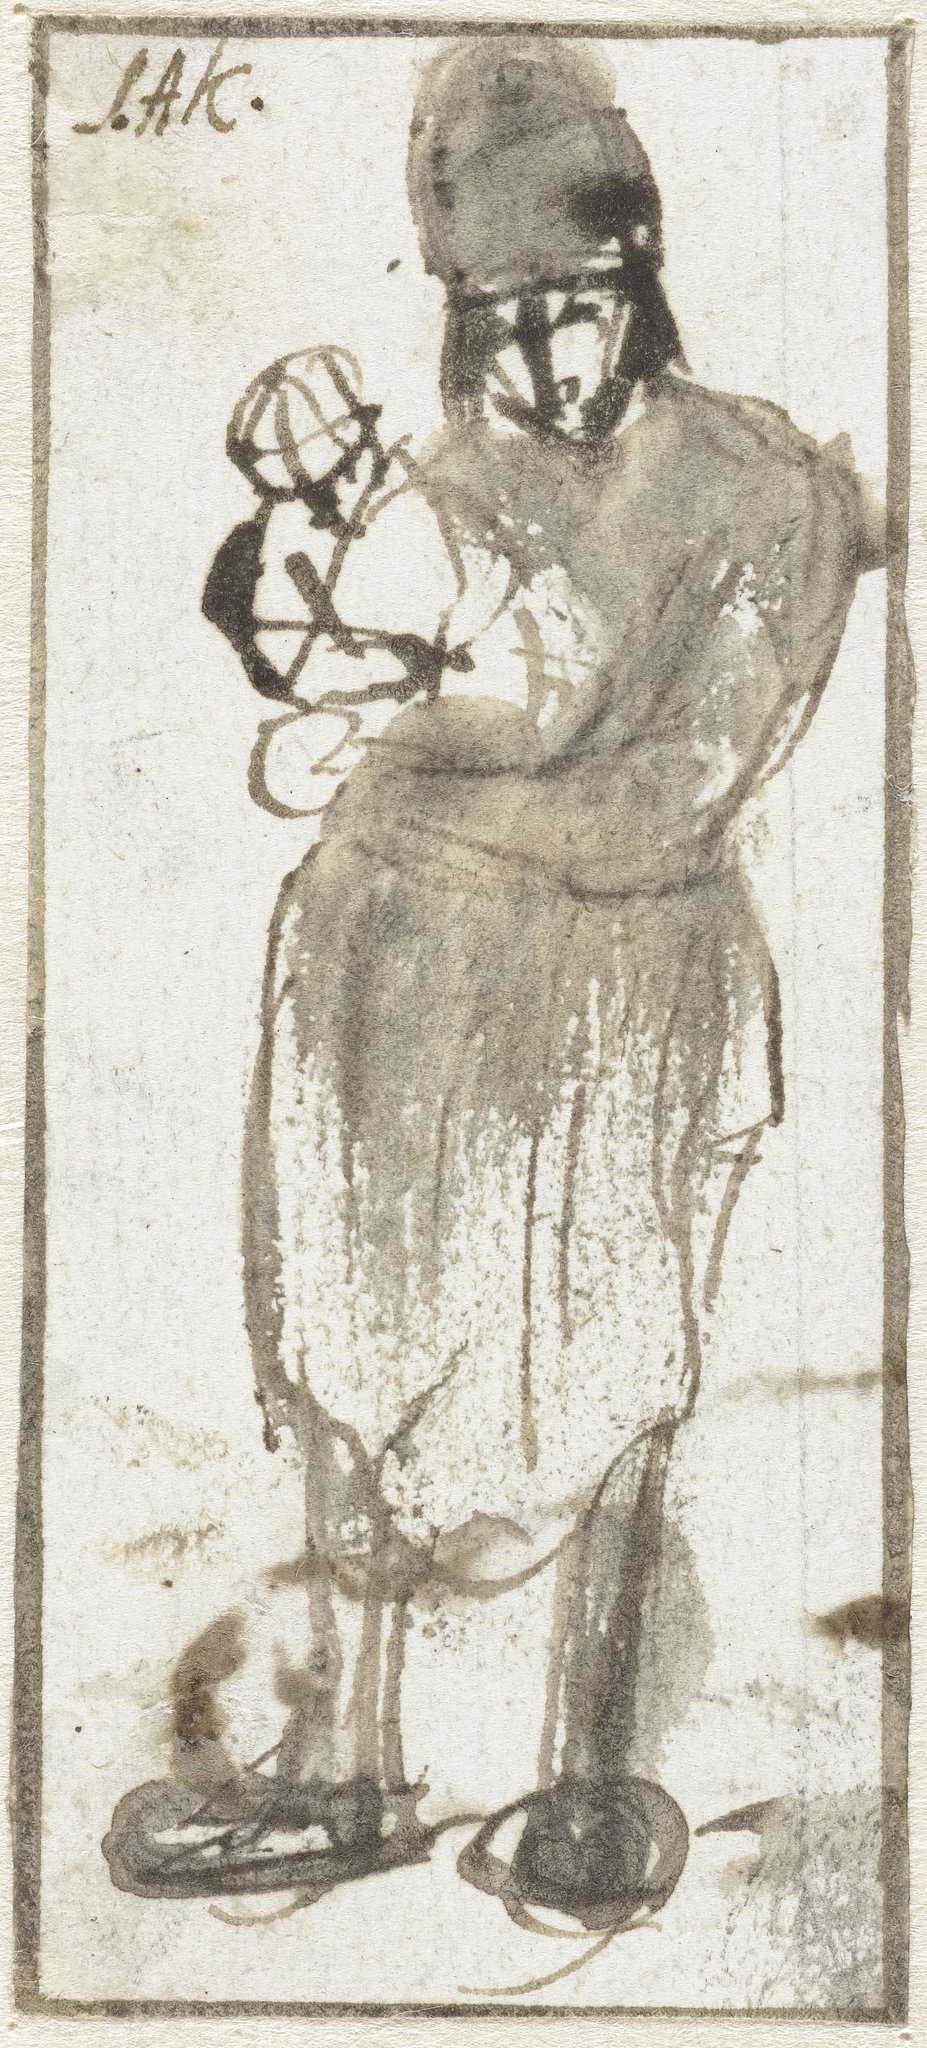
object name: drawing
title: Staand persoon met kind op de arm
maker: simon andreas krausz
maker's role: draughtsman, print maker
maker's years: 1760-1825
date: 1770-1825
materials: ink, paper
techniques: brush, pen